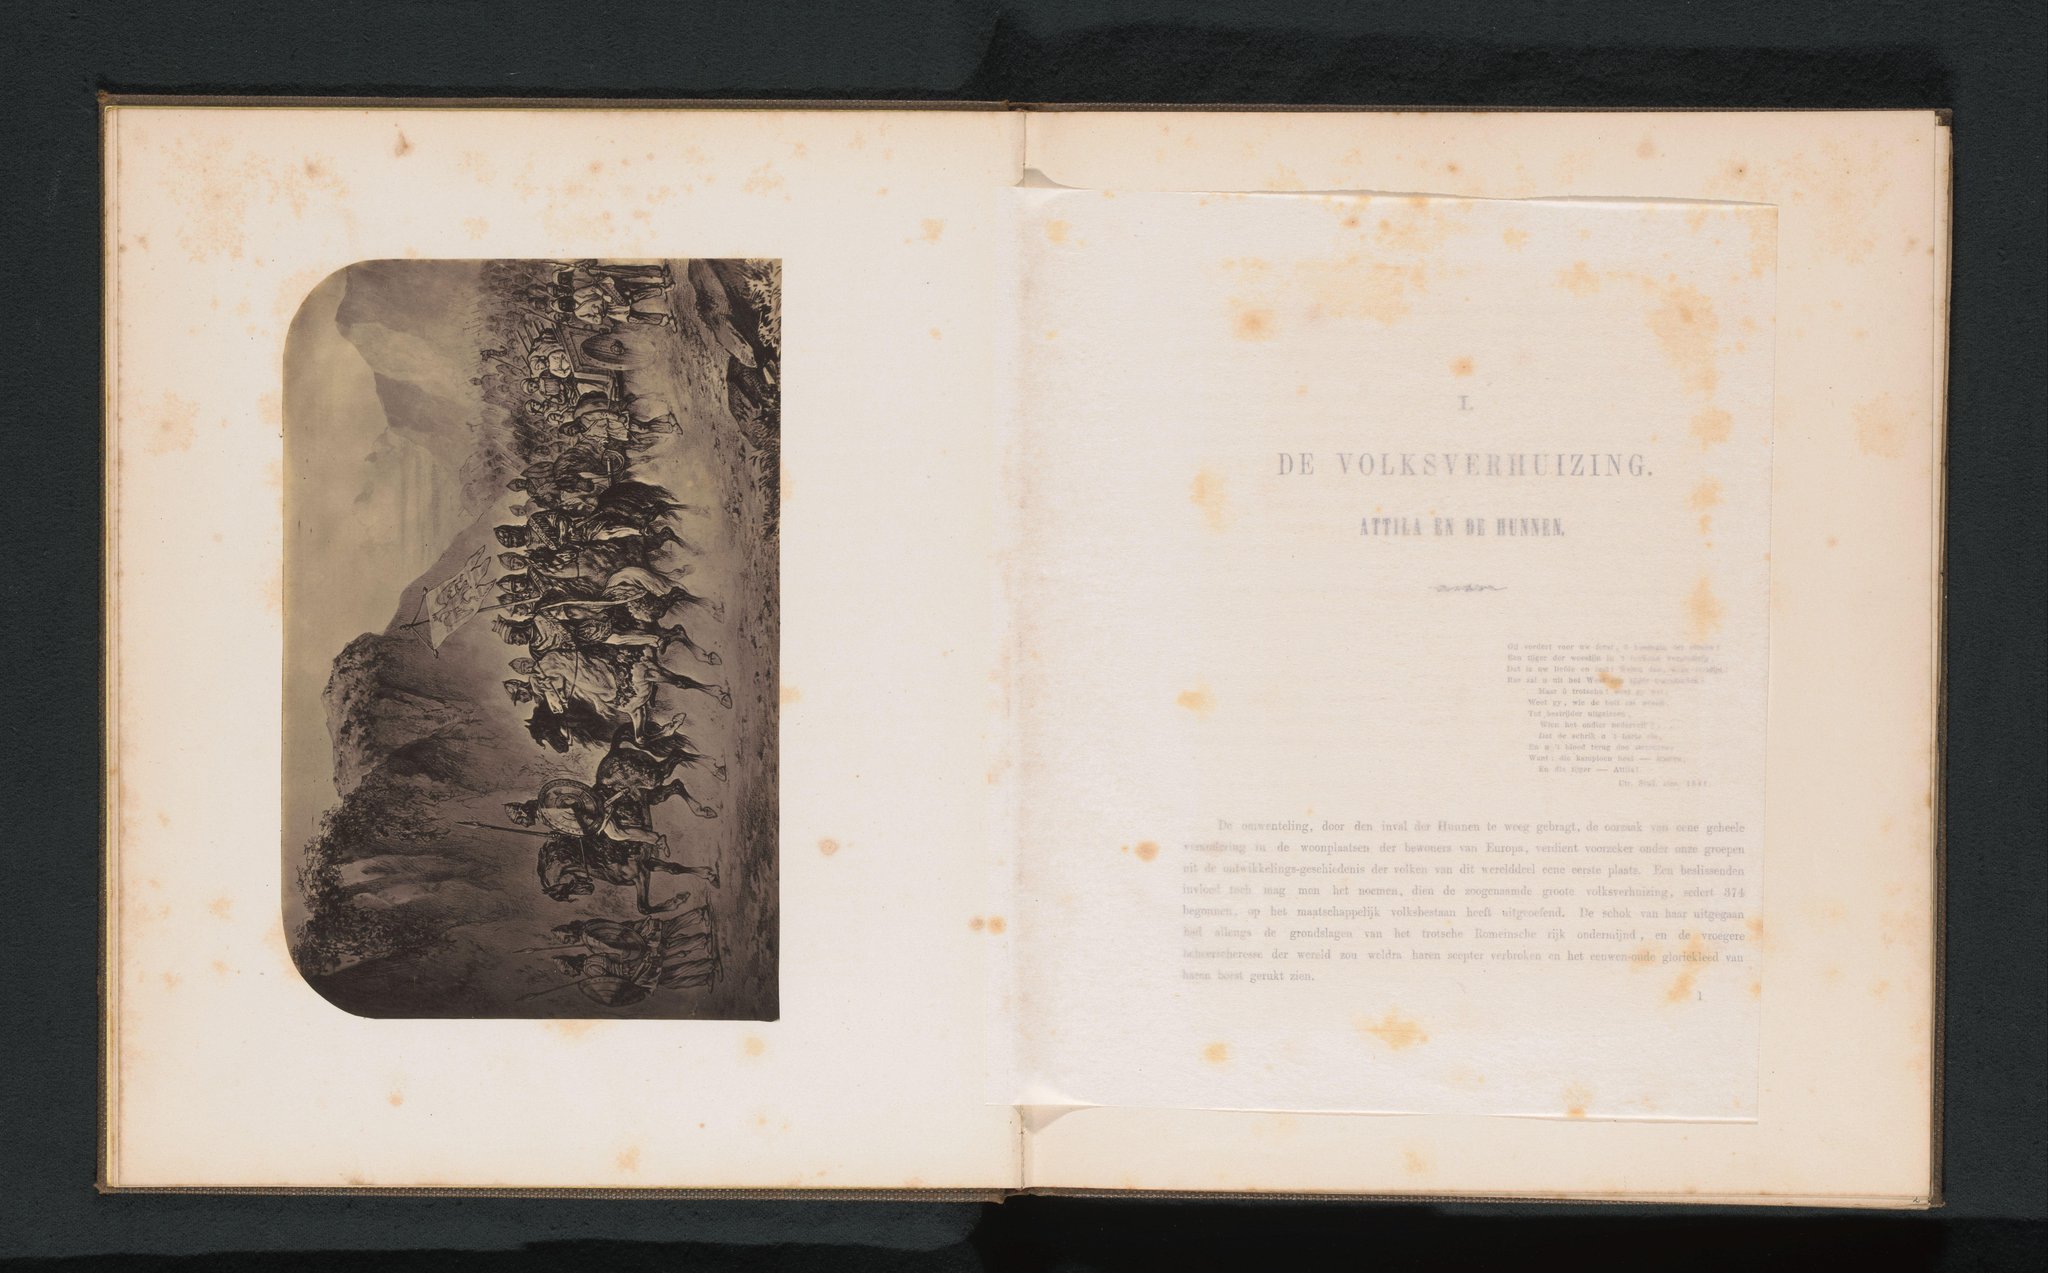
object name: photograph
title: Fotoreproductie van een prent van Attila en de Hunnen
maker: Anonymous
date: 1856-1861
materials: photographic support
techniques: albumen print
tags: army 'en route'